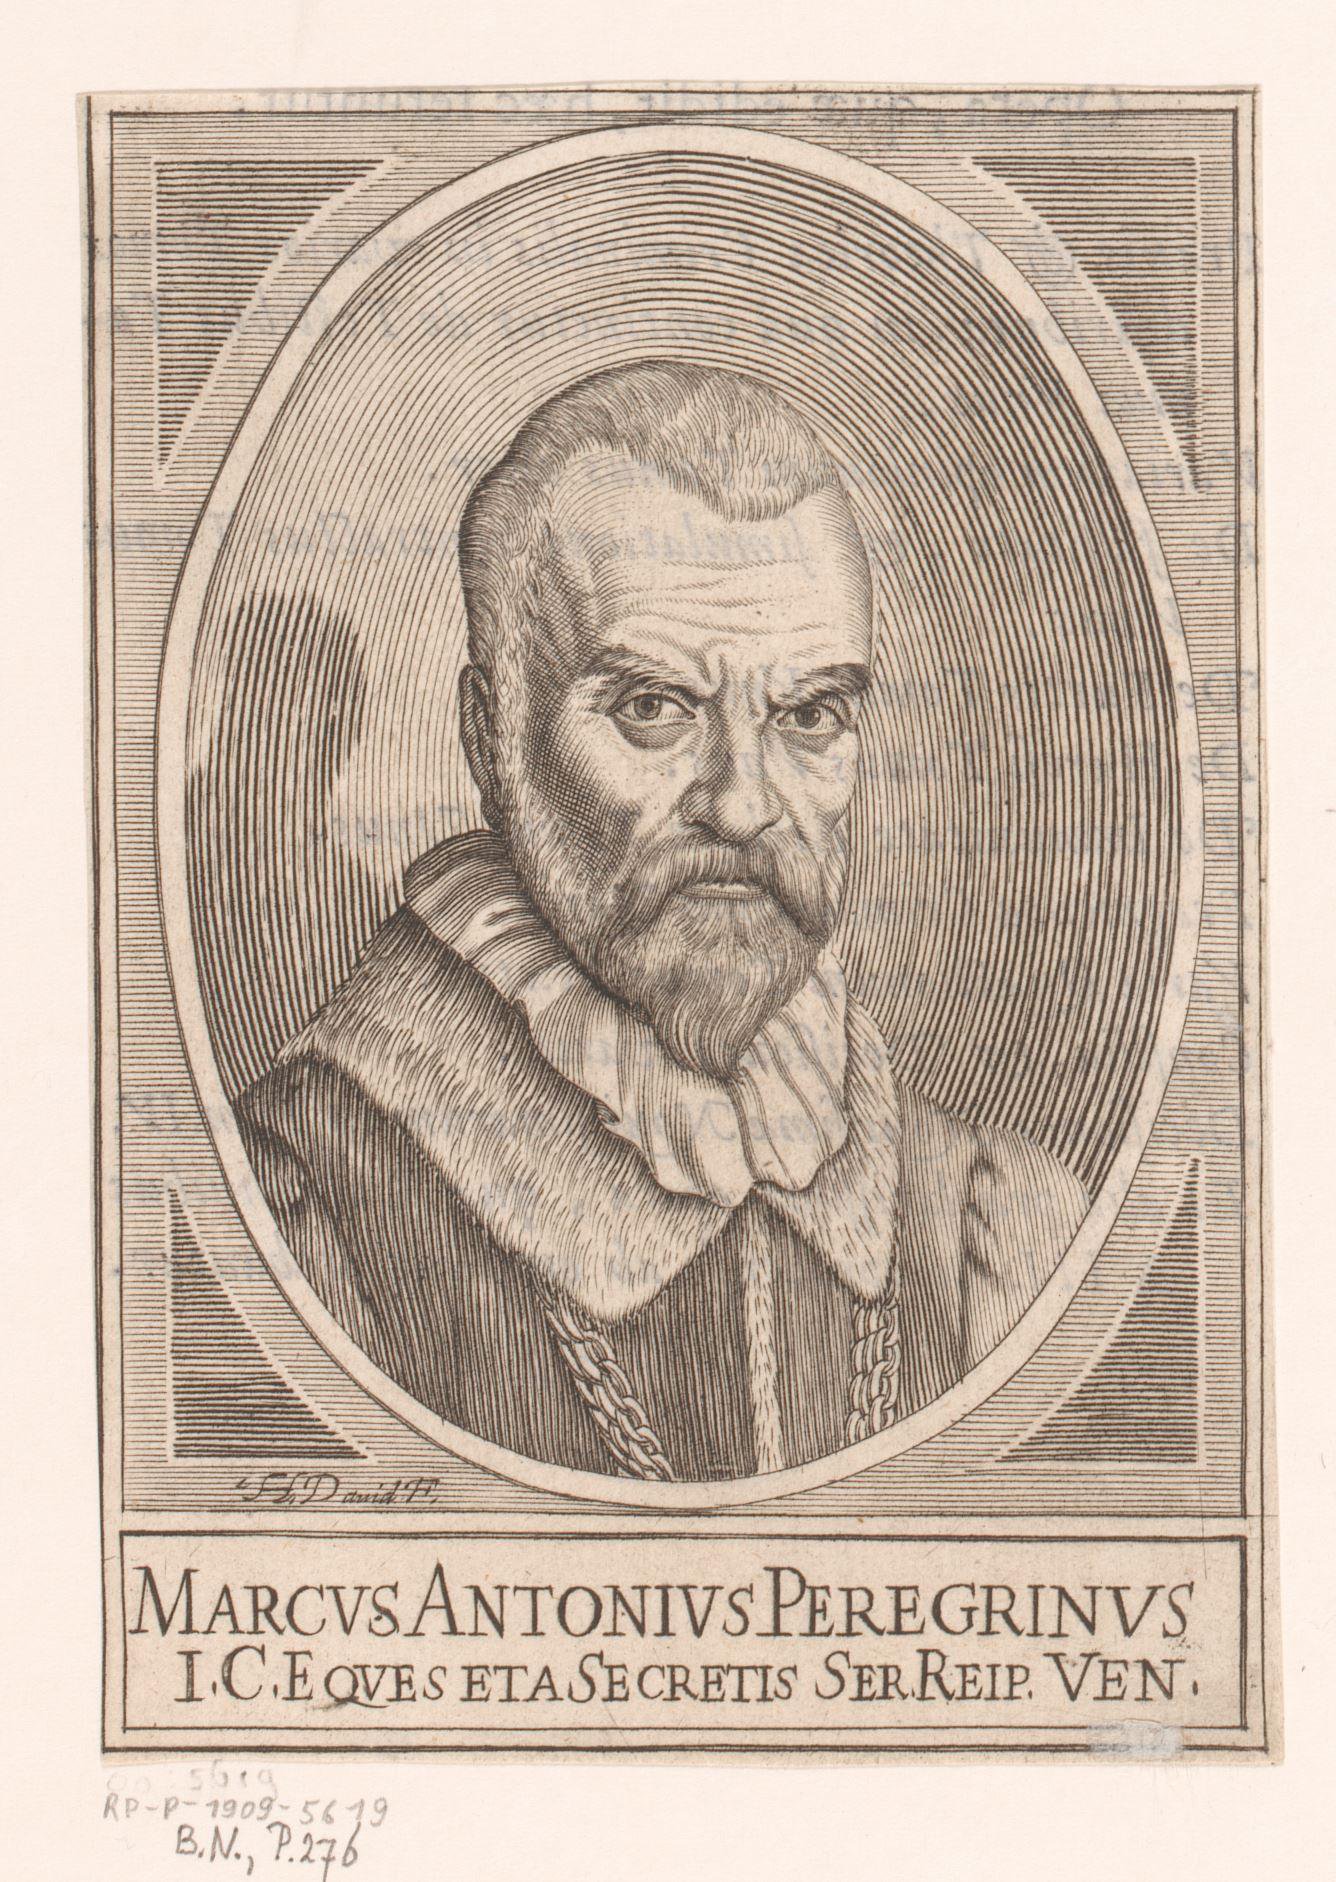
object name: book illustration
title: Marcus Antonius Peregrinus I.C.E ques eta Secretis Ser. Reip. Ven.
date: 1630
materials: paper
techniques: engraving, letterpress printing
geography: france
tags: ornament ~ medallion, historical persons, lawyer, attorney at law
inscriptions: collector's mark: Lugt 2228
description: Prent uit: Tomasini, Jacopo Filippo. Jacobi Philippi Tomasini Patavini Illustrium Virorum Elogia Iconibus Exornata (...). Padua: Donato Pasquardi, 1630, p. 276.